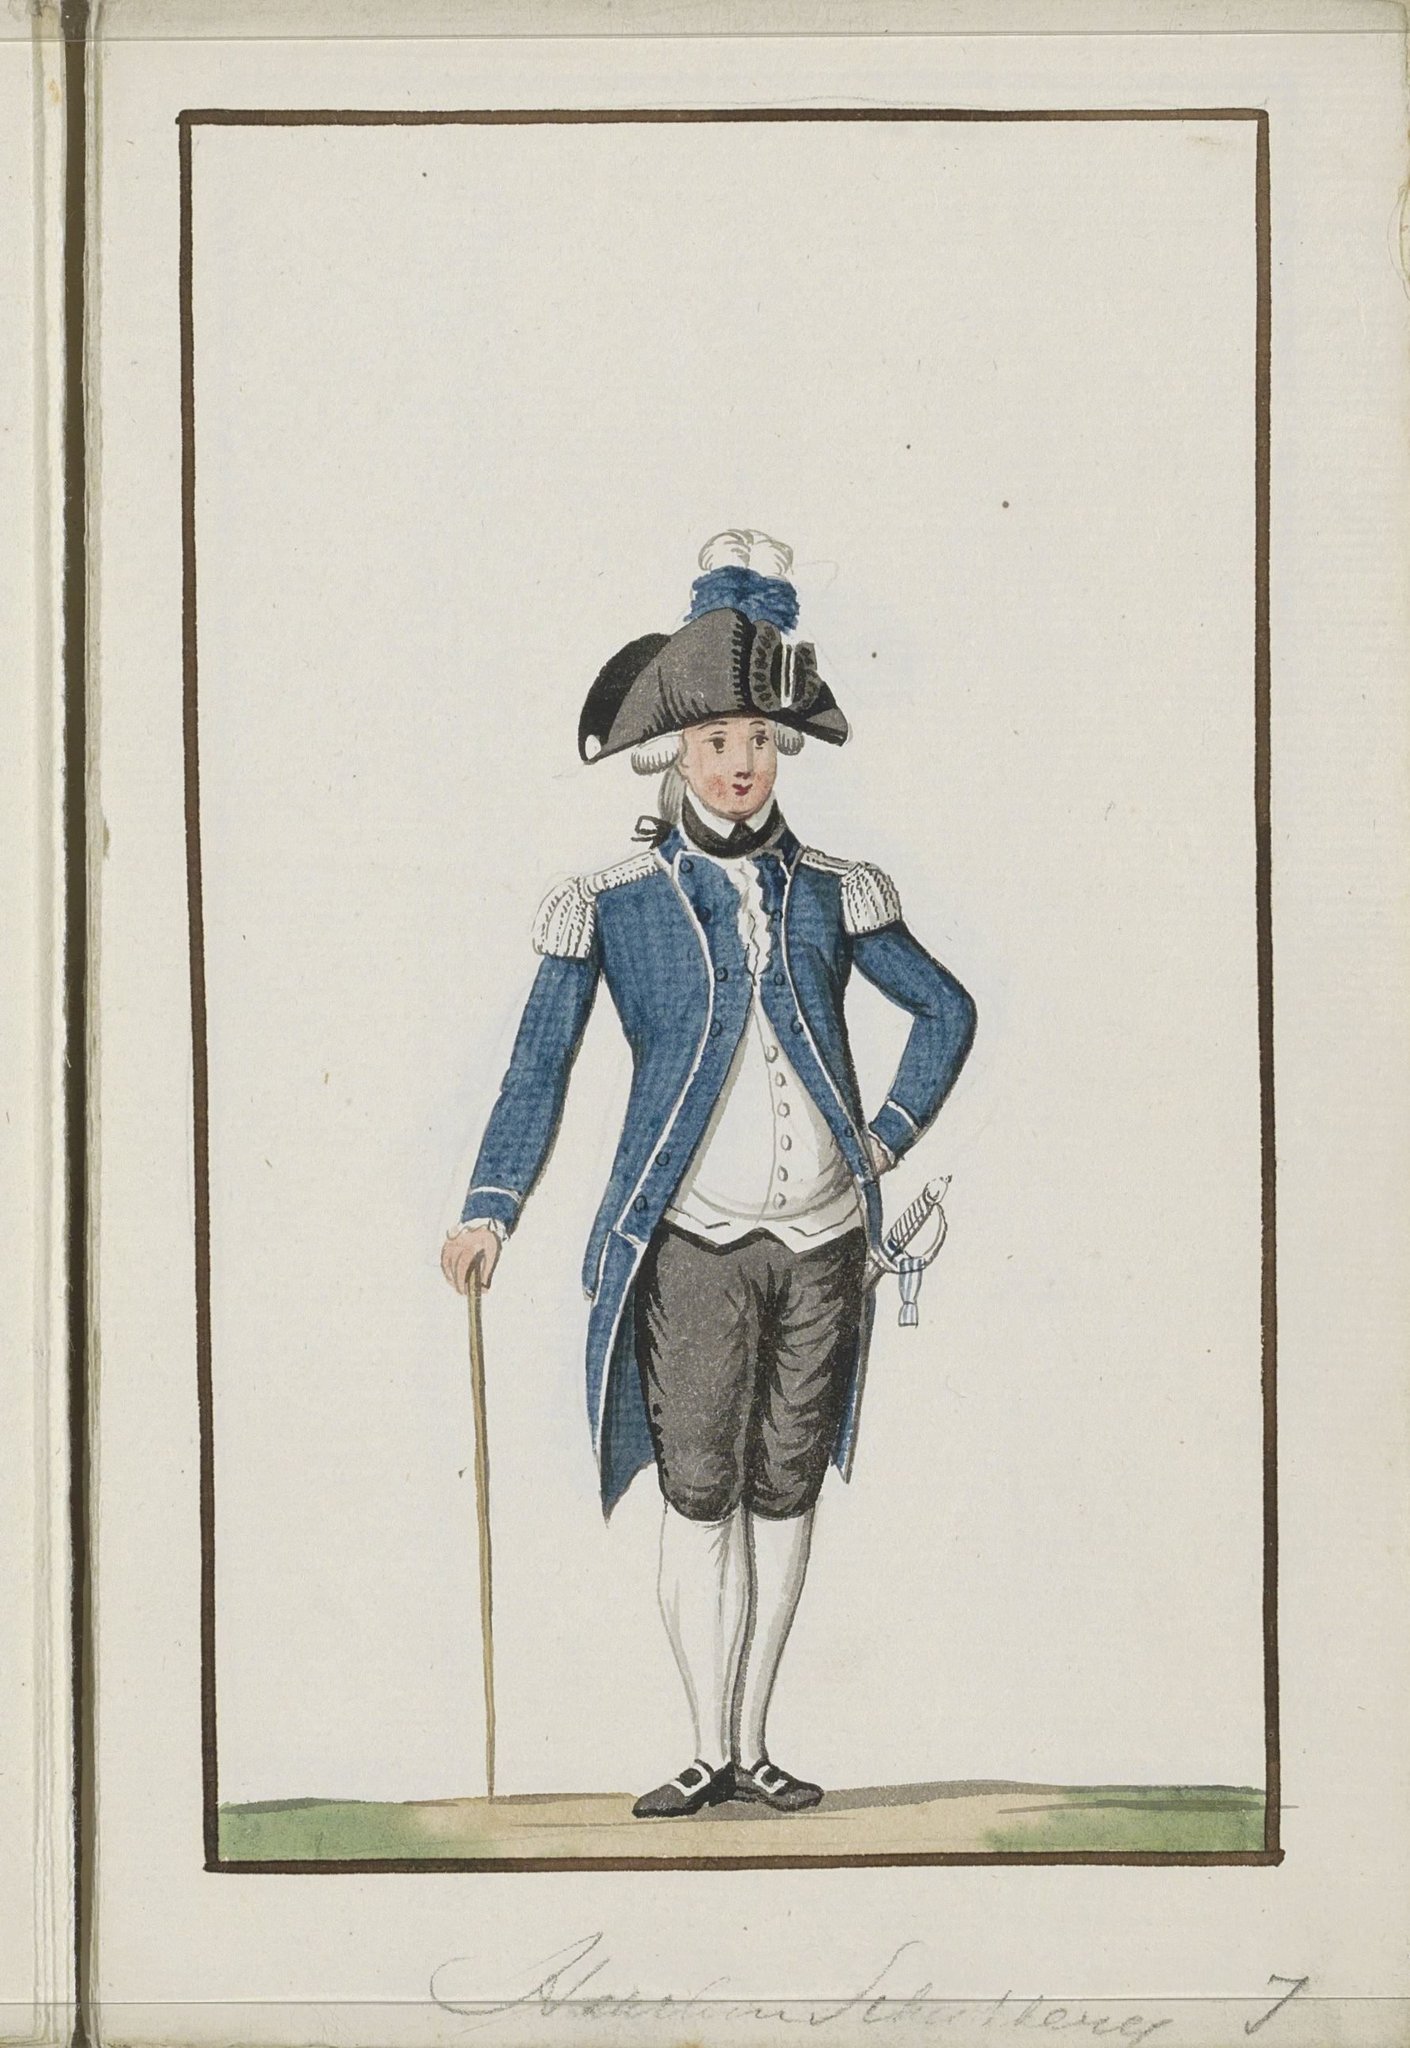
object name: drawing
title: Montering van de Haarlemse schutterij, ca. 1785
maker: Anonymous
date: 1789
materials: paper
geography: northern netherlands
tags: (military) uniforms (+ citizen soldiery, civil guard, citizen militia), haarlem, patriots (1780-1795)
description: Montering of uniform van de Haarlemse schutterij, ca. 1785. Onderdeel van een schetsboek met 41 gekleurde tekeningen van de monteringen van de gewapende schutterijen en burgercorpsen in Nederland in de periode ca. 1783-1789.